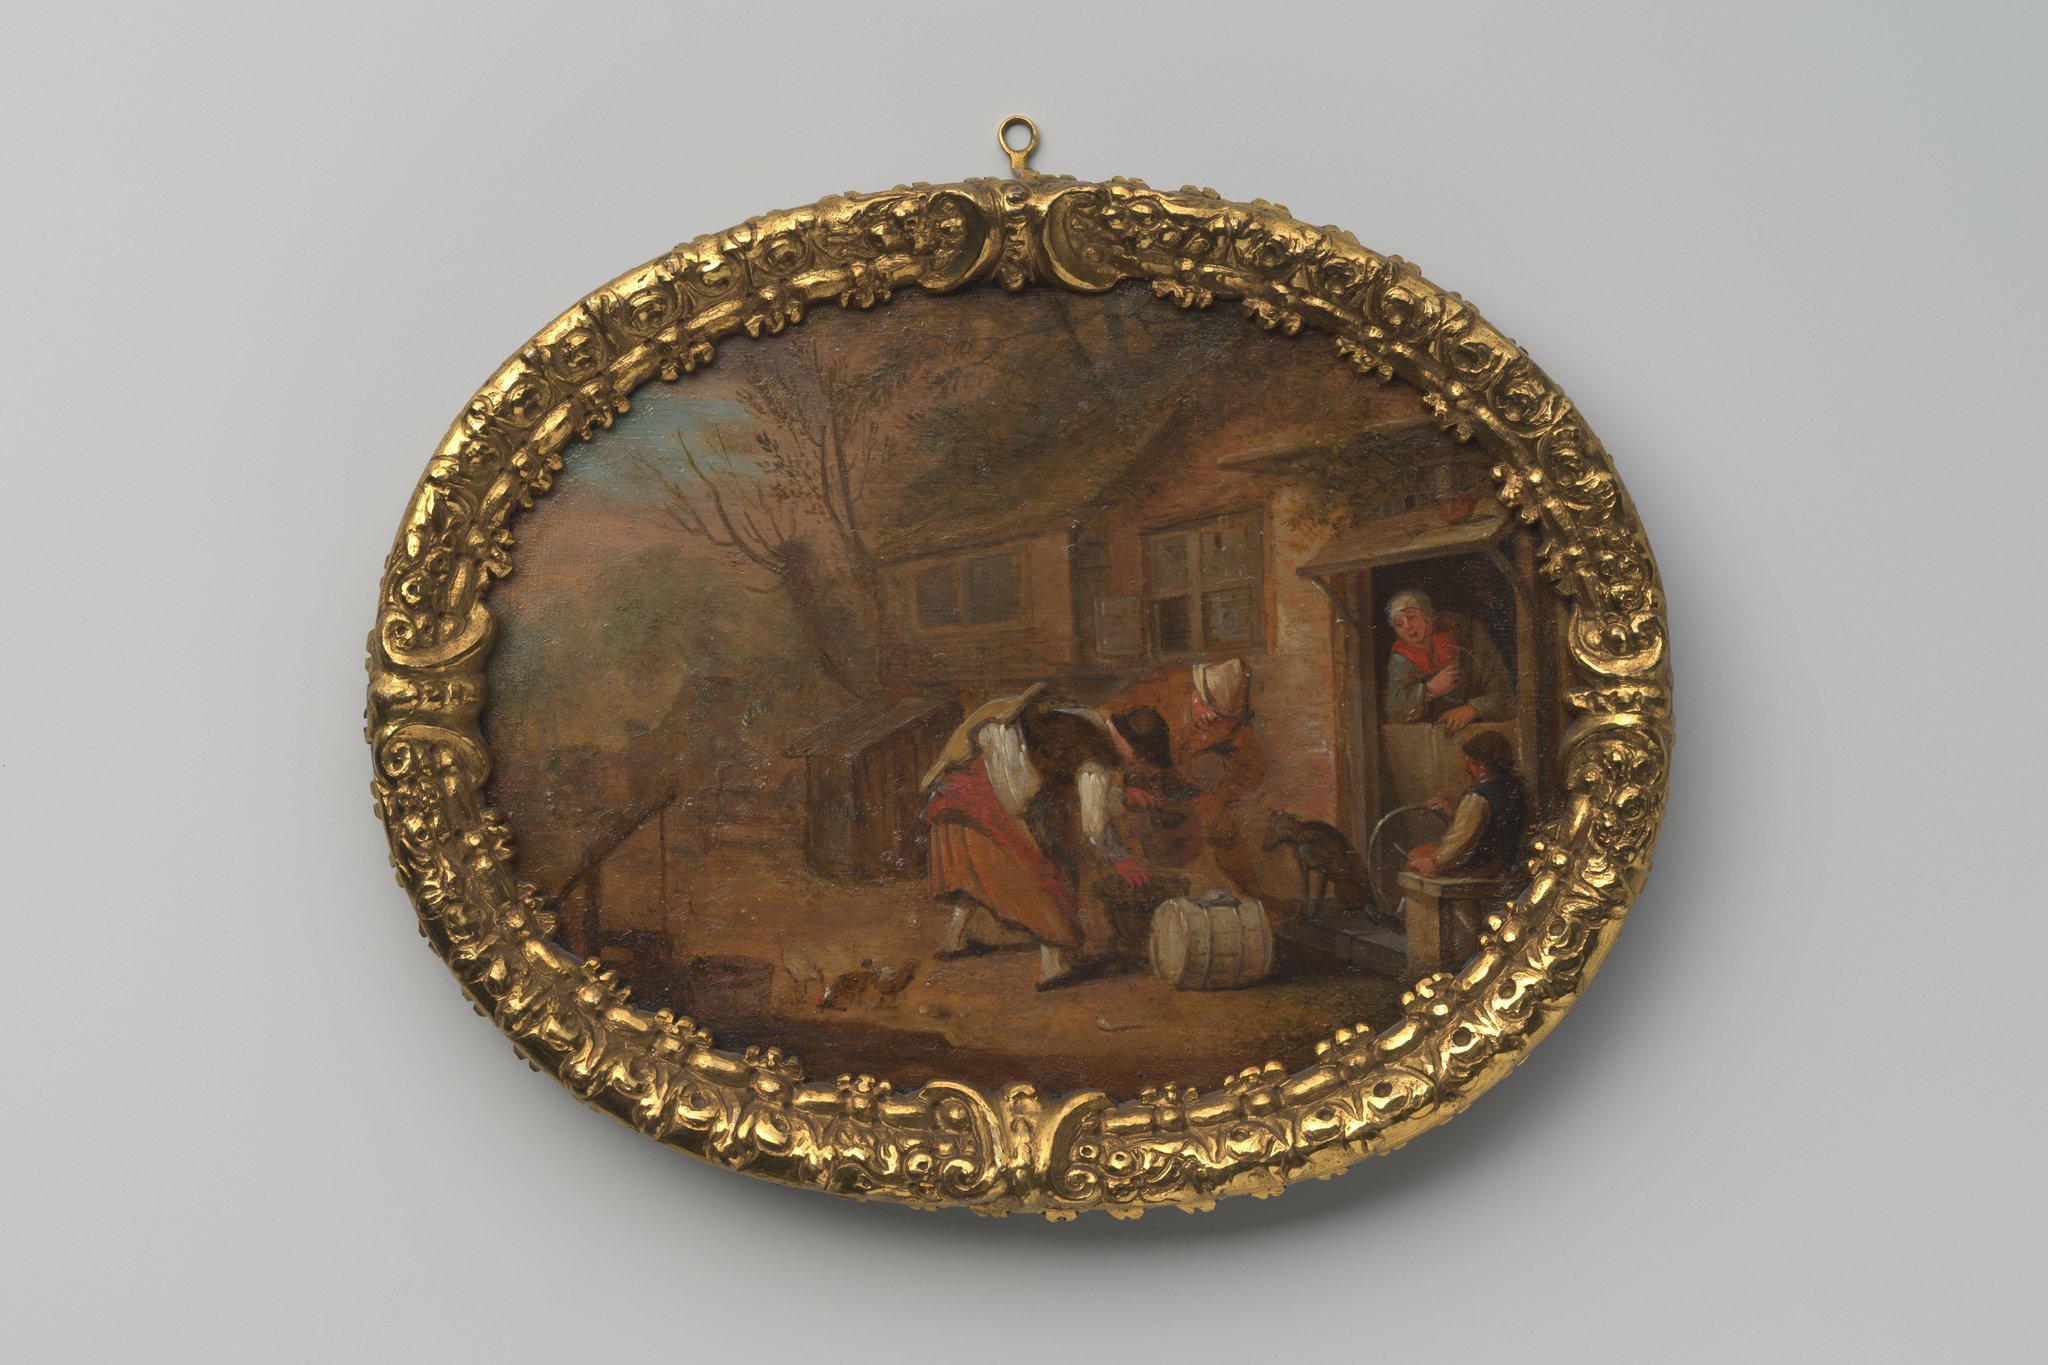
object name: miniature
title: The Street Seller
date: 1690-1710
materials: bronze, oil, metal alloy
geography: amsterdam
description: Voor een huis biedt een vrouw haar koopwaar aan. Een man kijkt belangstellend toe. In de deuropening staat een vrouw. Rechts van de deur staat een jongen met een hoepel. Links op de voorgrond bevindt zich een waterput.